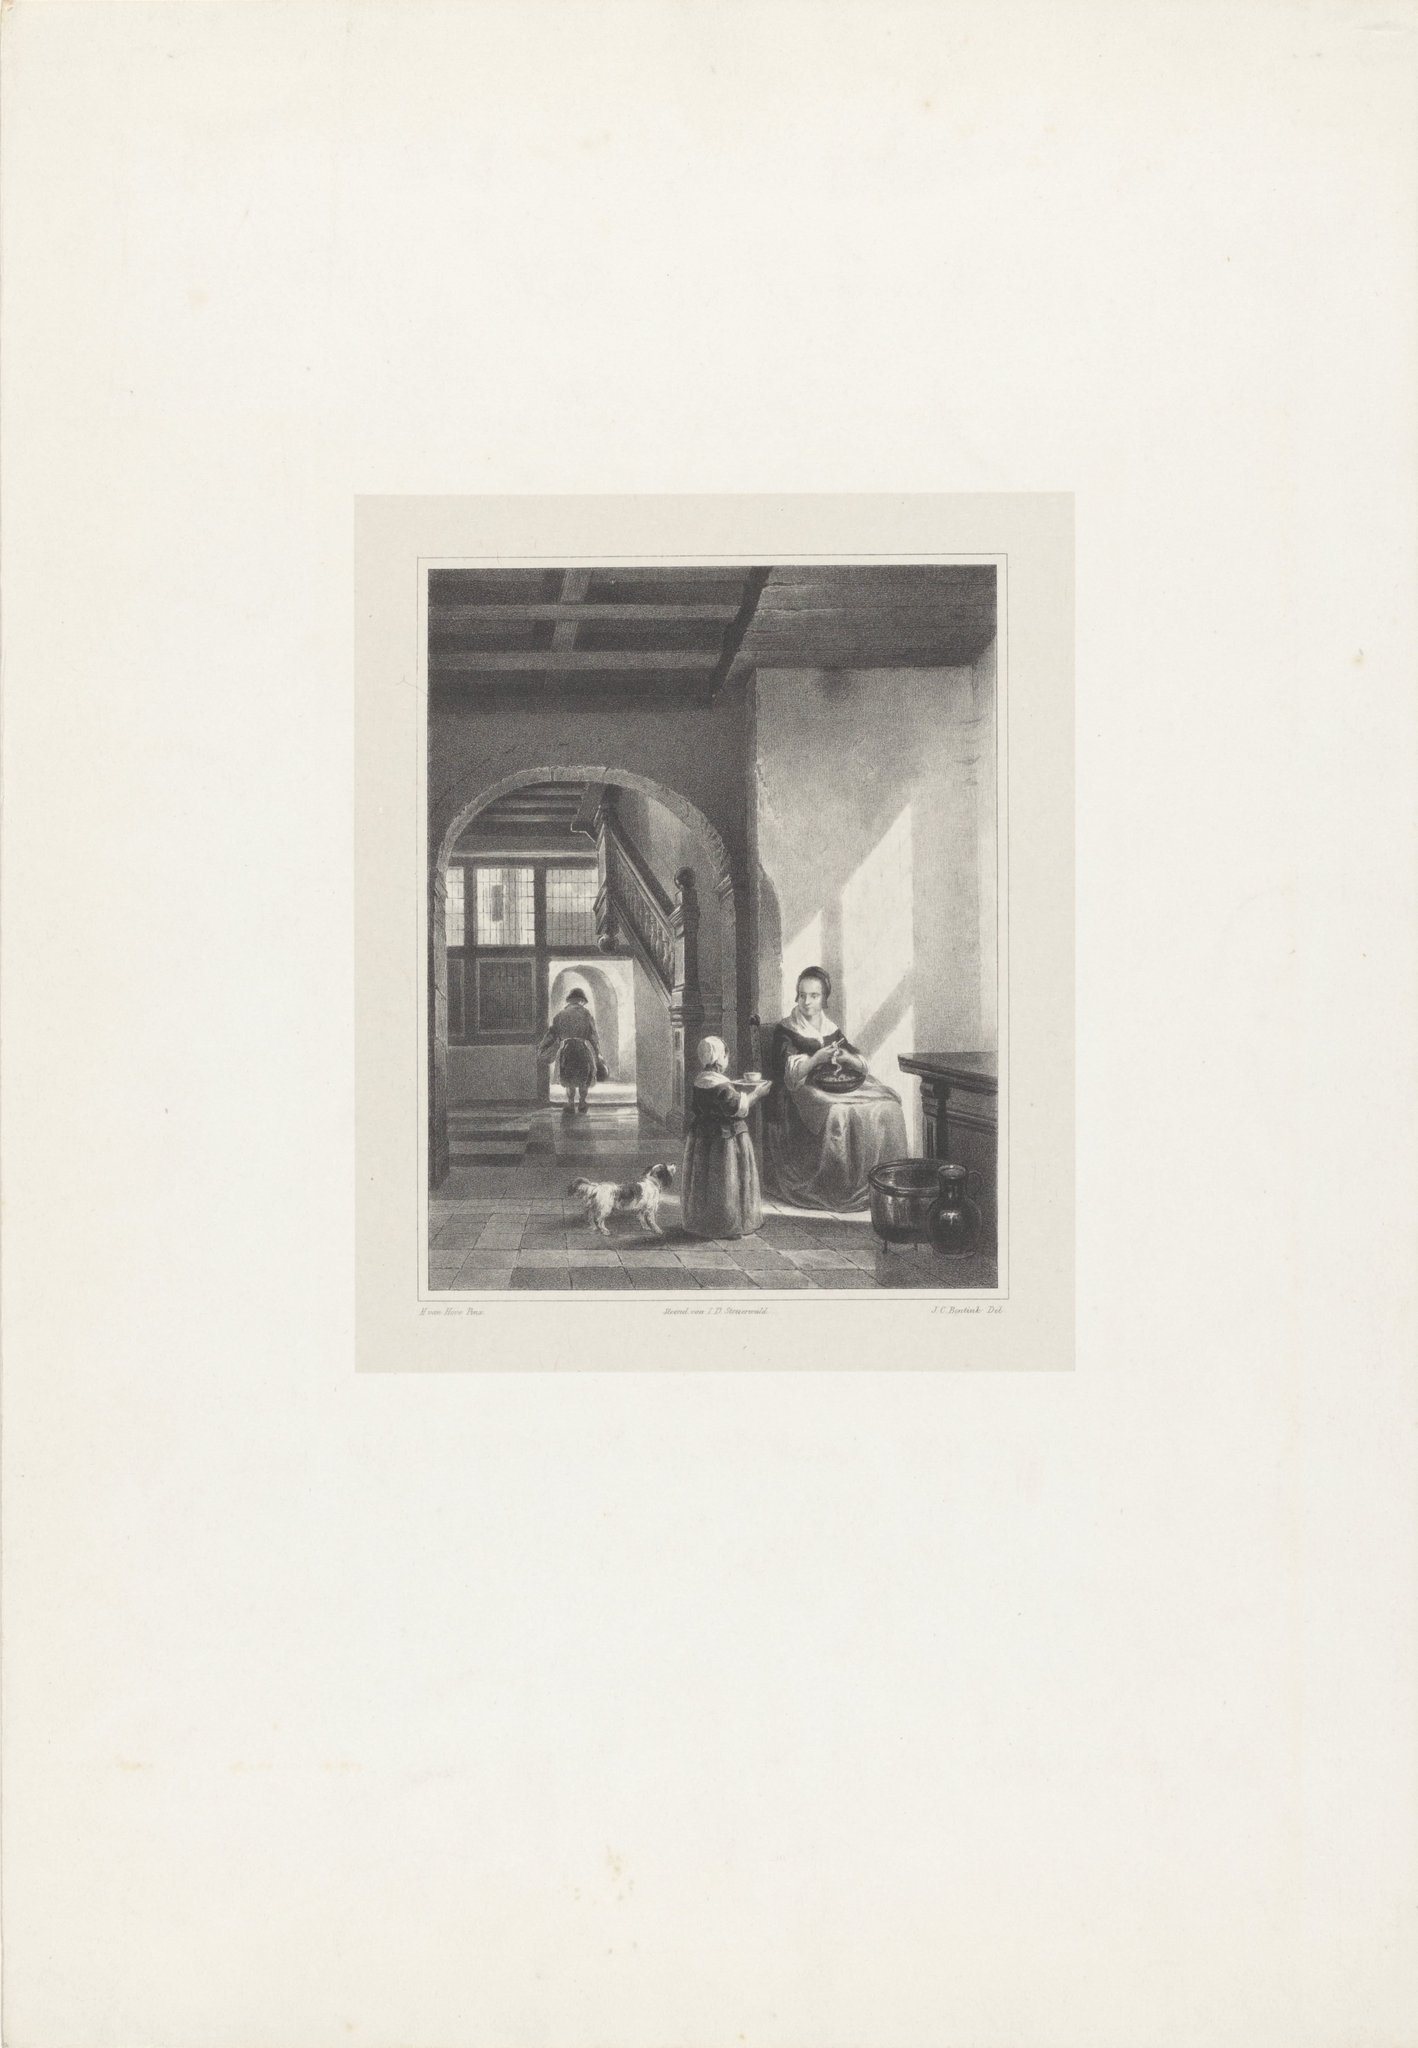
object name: print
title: Aardappel schillende vrouw in Hollands interieur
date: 1824-1849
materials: paper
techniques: lithograph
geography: netherlands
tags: interior of the house, potatoes, house personnel, servants, dog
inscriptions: collector's mark: Lugt 2228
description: De vrouw zit bij het raam. Een meisje brengt haar een kop en schotel. Naast haar staat een hond. In de achtergrond loopt een figuur door de deur naar buiten.